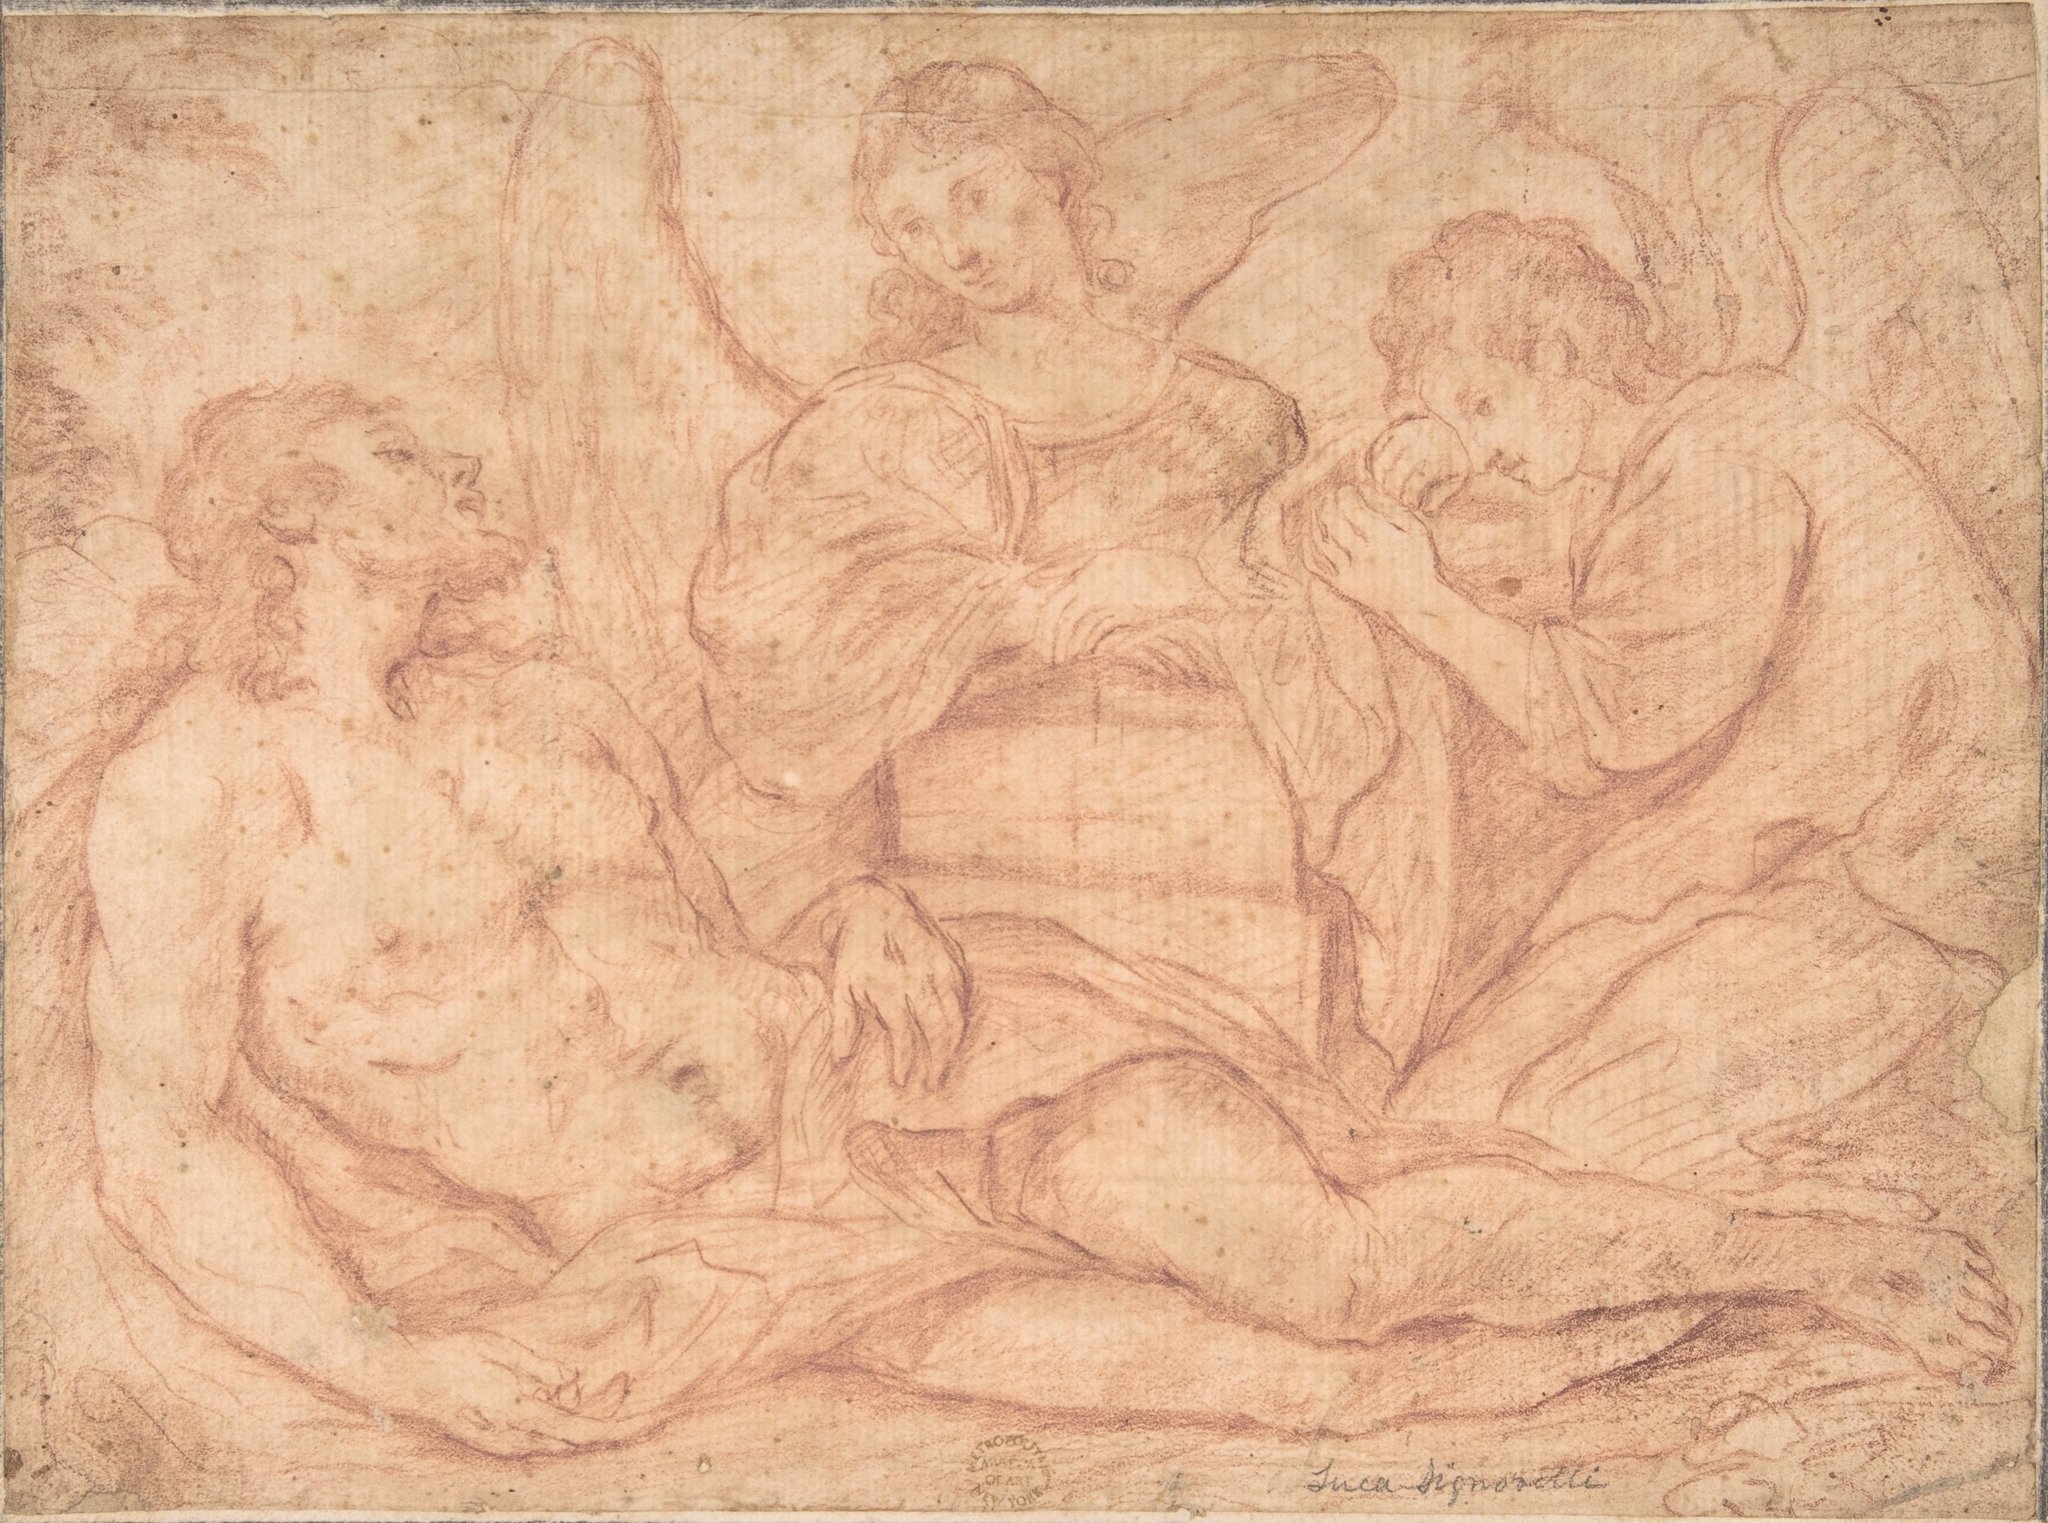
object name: drawing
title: Dead Christ Mourned Over by Angels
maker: anonymous, italian, roman-bolognese, 17th century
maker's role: artist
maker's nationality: italian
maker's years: 1600-1700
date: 1601-1700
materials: chalk, paper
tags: angels,christ,death